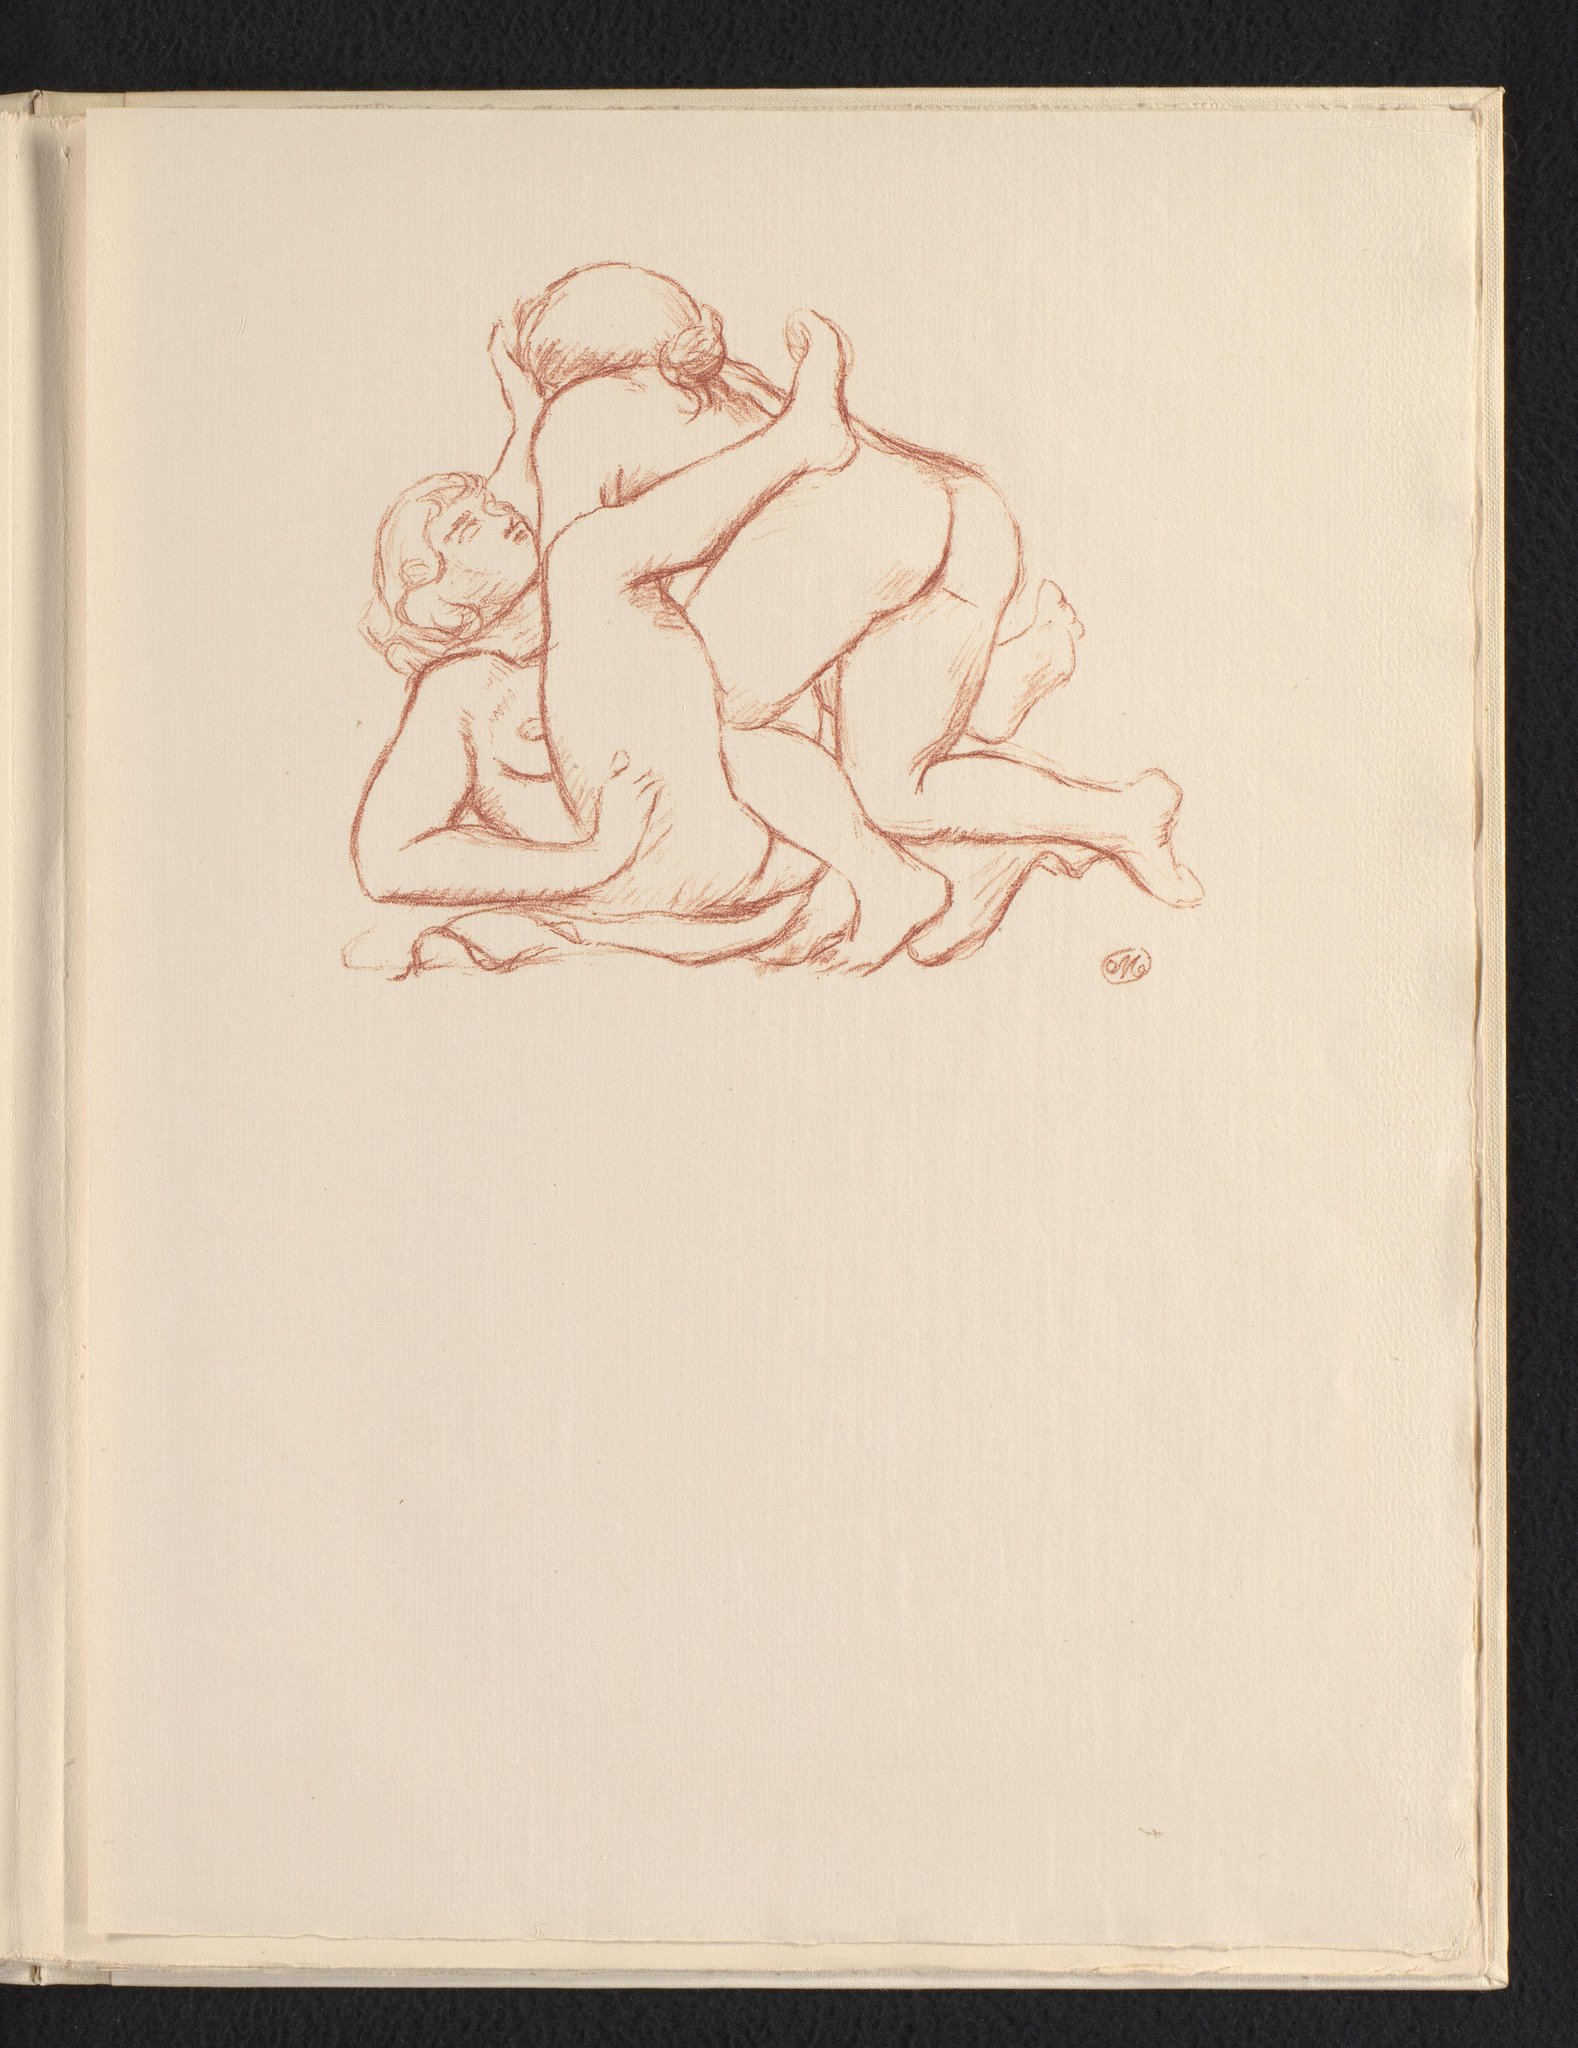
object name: page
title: Vrijend paar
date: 1948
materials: paper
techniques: lithograph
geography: paris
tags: (showing oneself) undressed, quasi-nude, couple of lovers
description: Prent uit: Lucianus van Samosata. Dialogues des Courtisanes. [Vertaald uit het Grieks door] Charles Astruc. Parijs: s.n., 1948, deel van de suite met een extra afdruk van de prenten in sanguine.